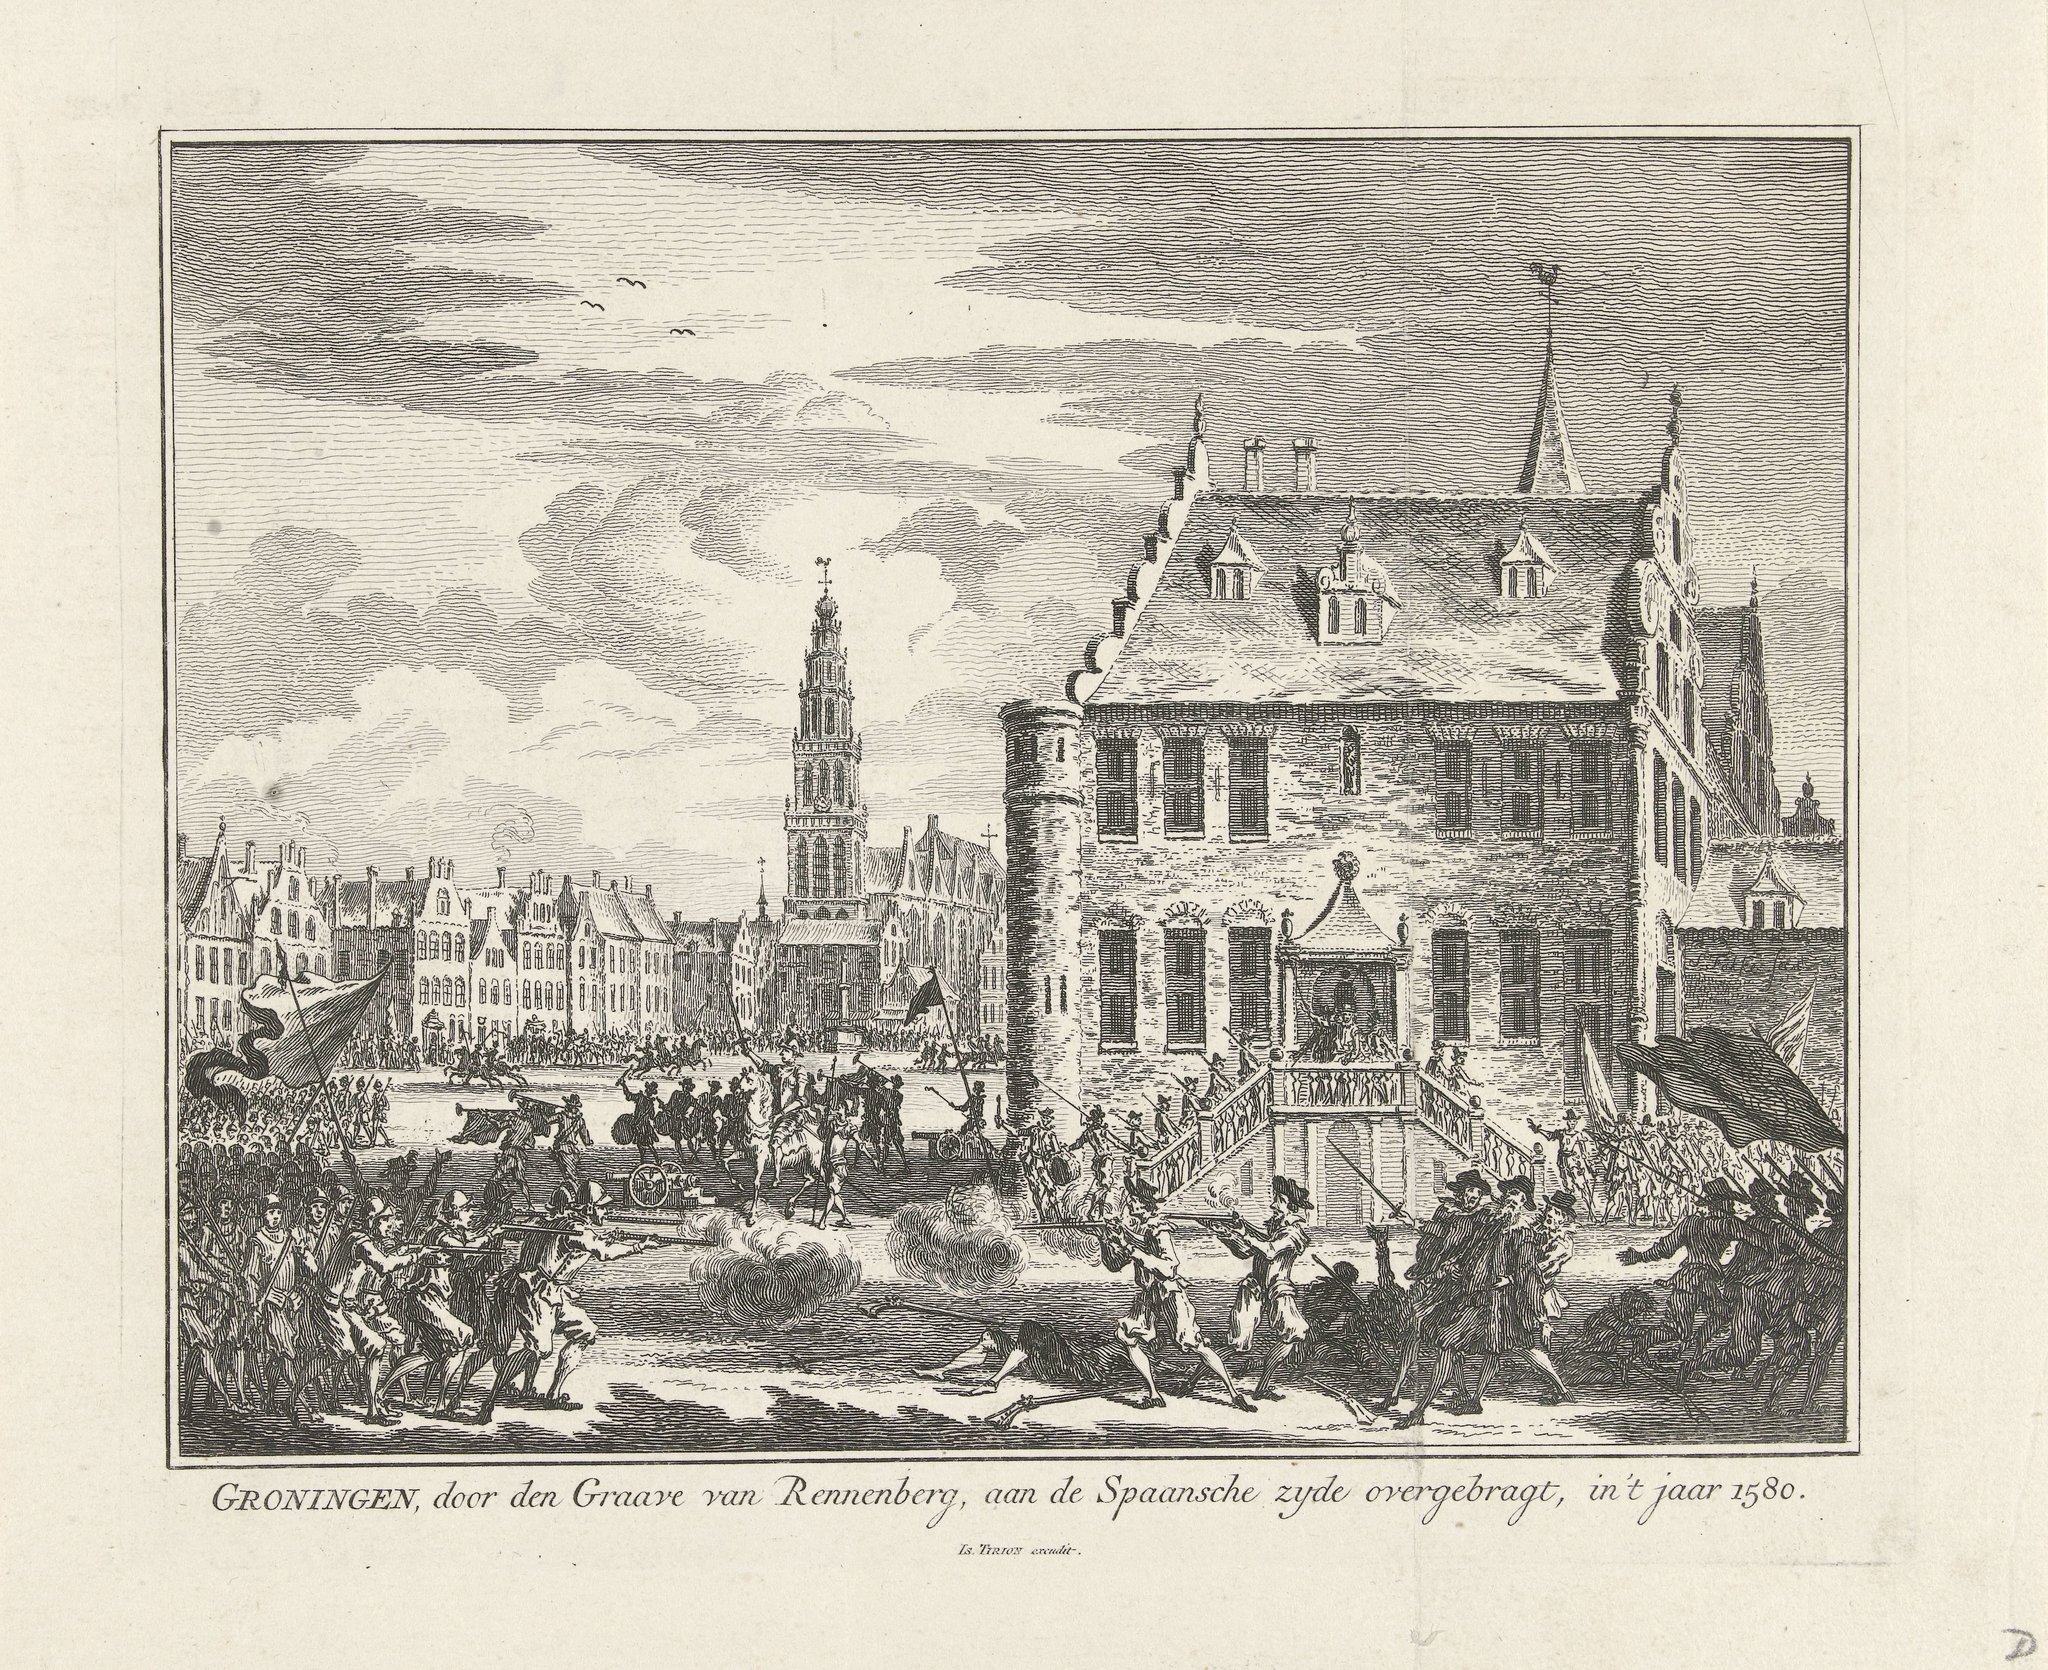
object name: print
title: Groningen, door den Graave van Rennenberg, aan de Spaansche zyde overgebragt, in 't jaar 1580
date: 1729-1766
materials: paper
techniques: etching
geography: amsterdam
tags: politician, treason, traitor to one's country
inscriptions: collector's mark: Lugt 2228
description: Gewapende optochten met schutters in de stad Groningen ten tijde van de overgang van graaf van Rennenberg naar Spaanse zijde. Op de voorgrond wordt door enkele schutters geschoten.